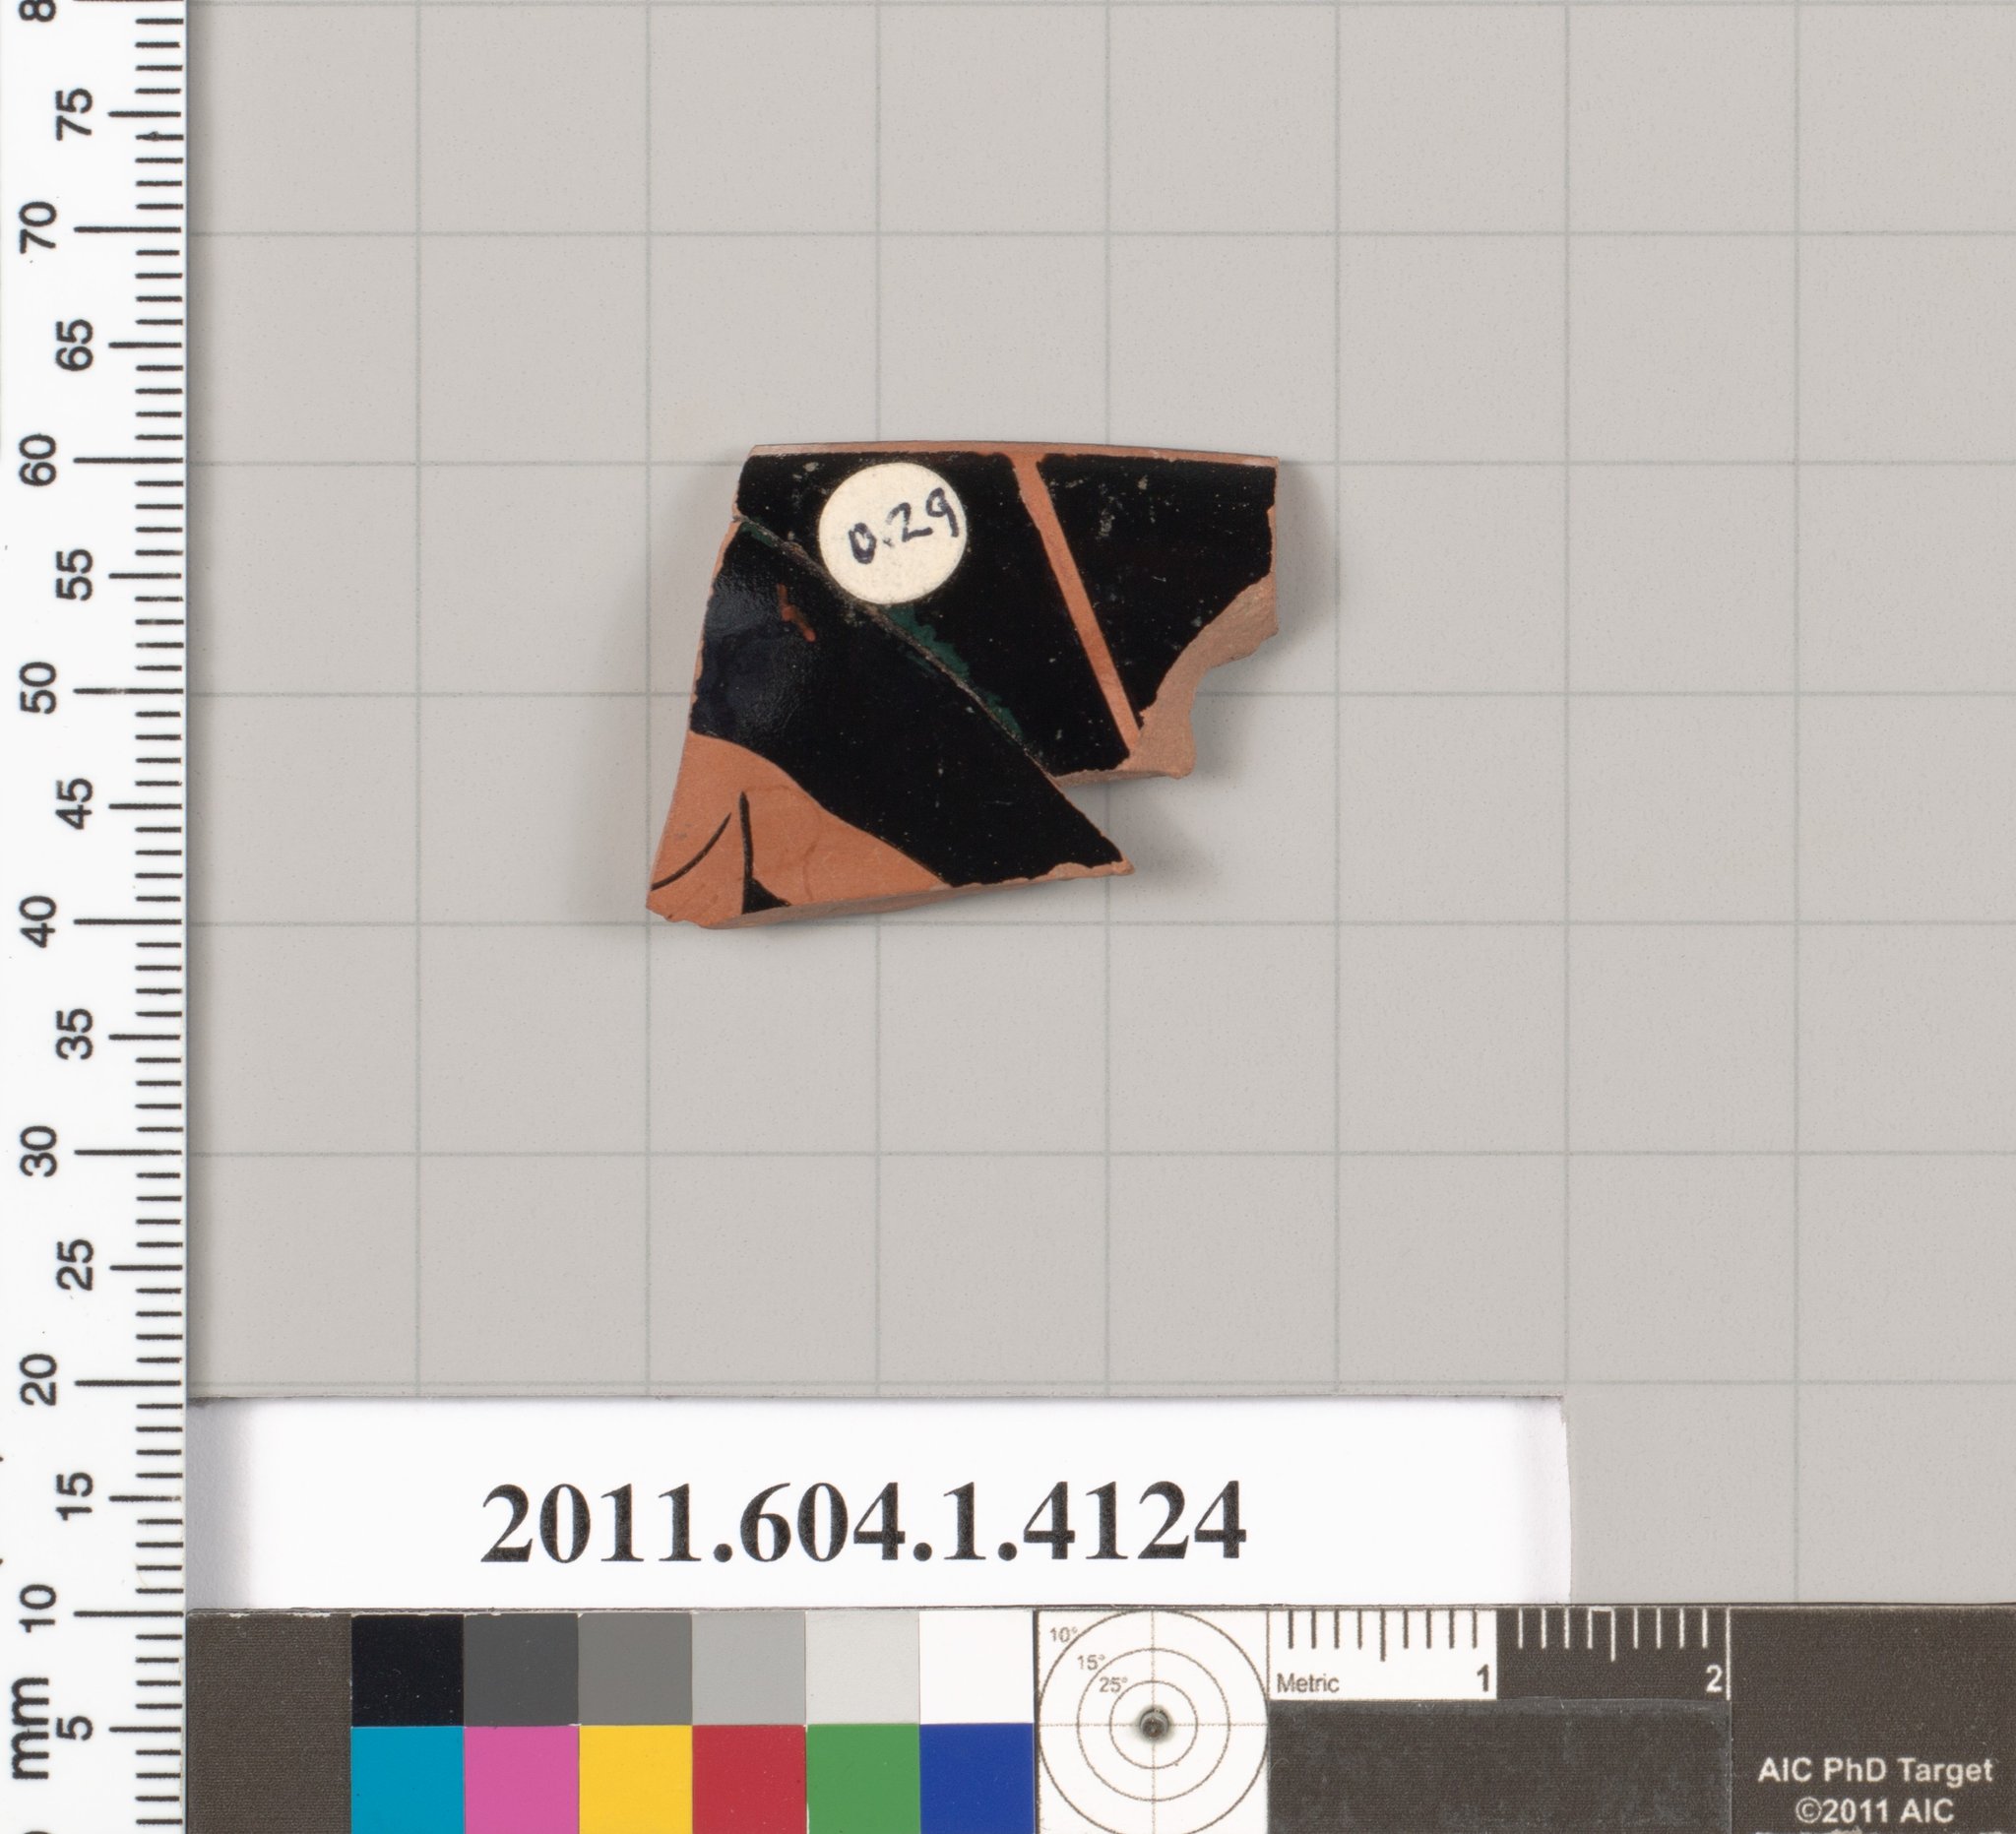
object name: kylix fragment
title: Terracotta rim fragment of a kylix (drinking cup)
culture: greek, attic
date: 490-470 BCE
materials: terracotta